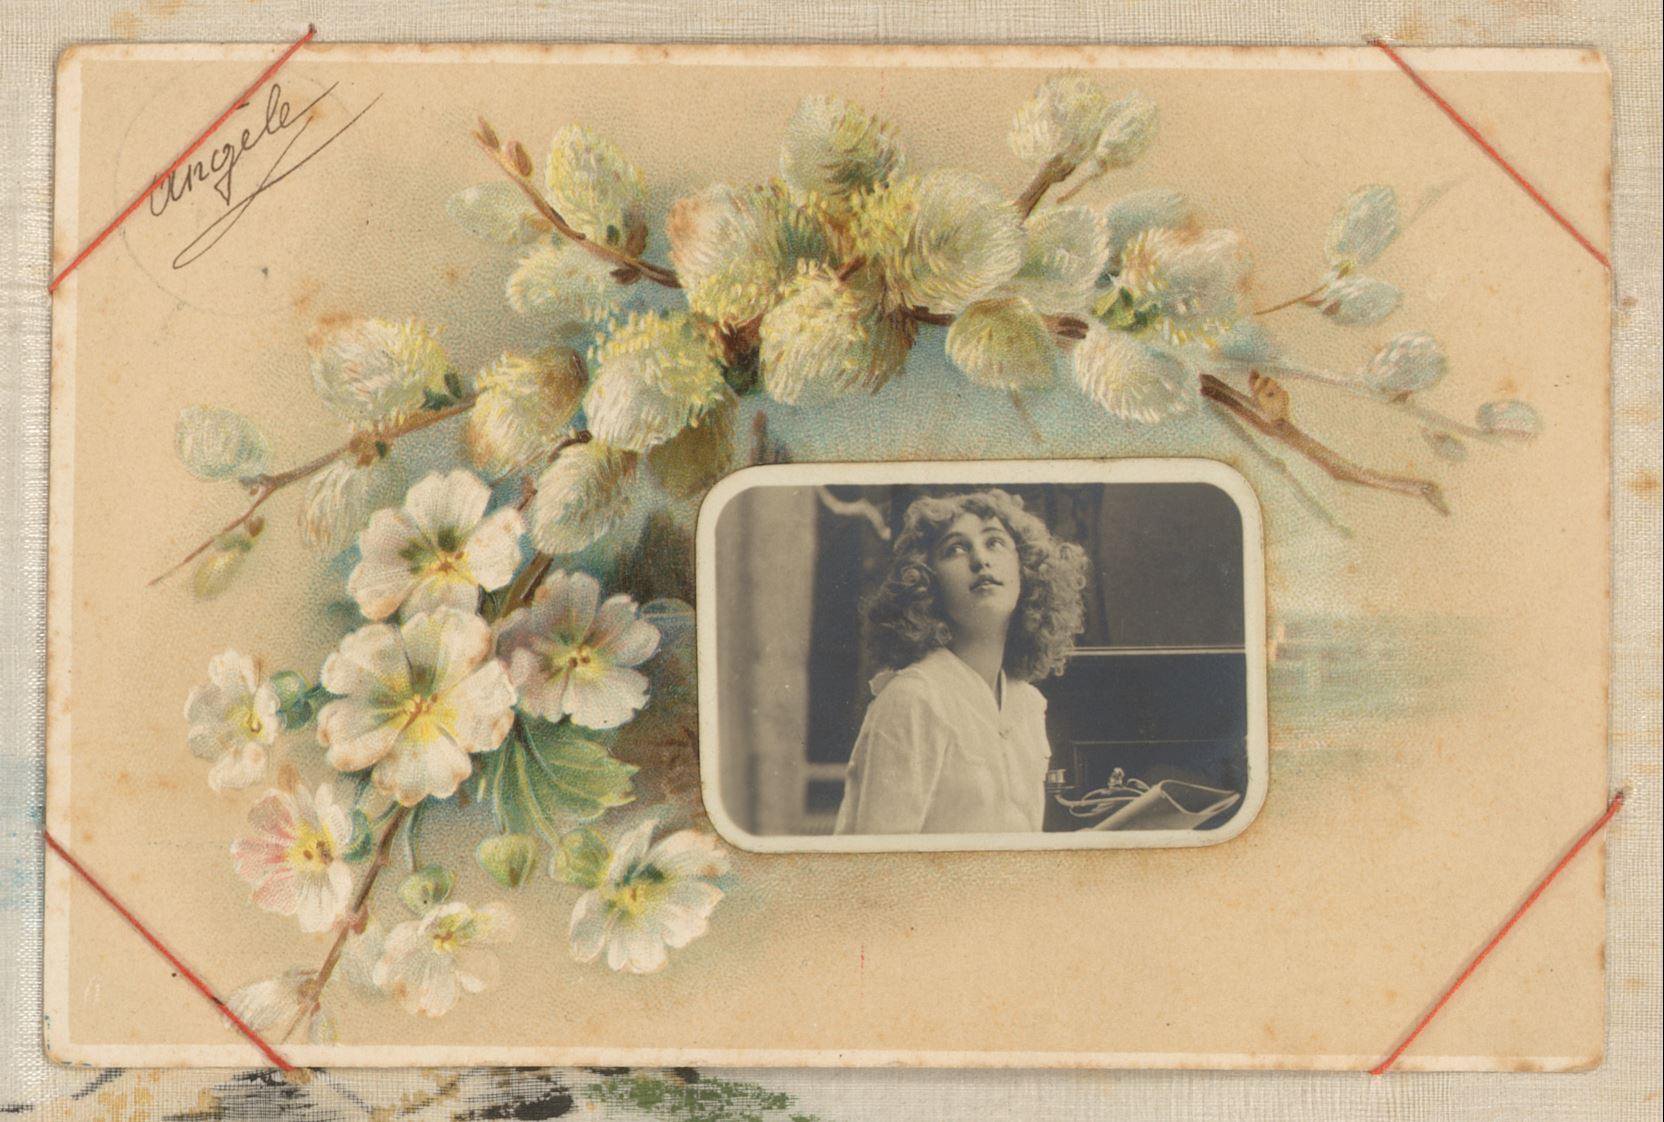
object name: album leaf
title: Portret van een vrouw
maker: Anonymous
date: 1880-1910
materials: cardboard, paint, photographic support, silk, textile, watercolor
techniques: blind stamped, brush, chromolithography, gelatin silver print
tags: trees (+ branch, stick), adult woman, historical persons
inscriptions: annotation: ‘Angèle’